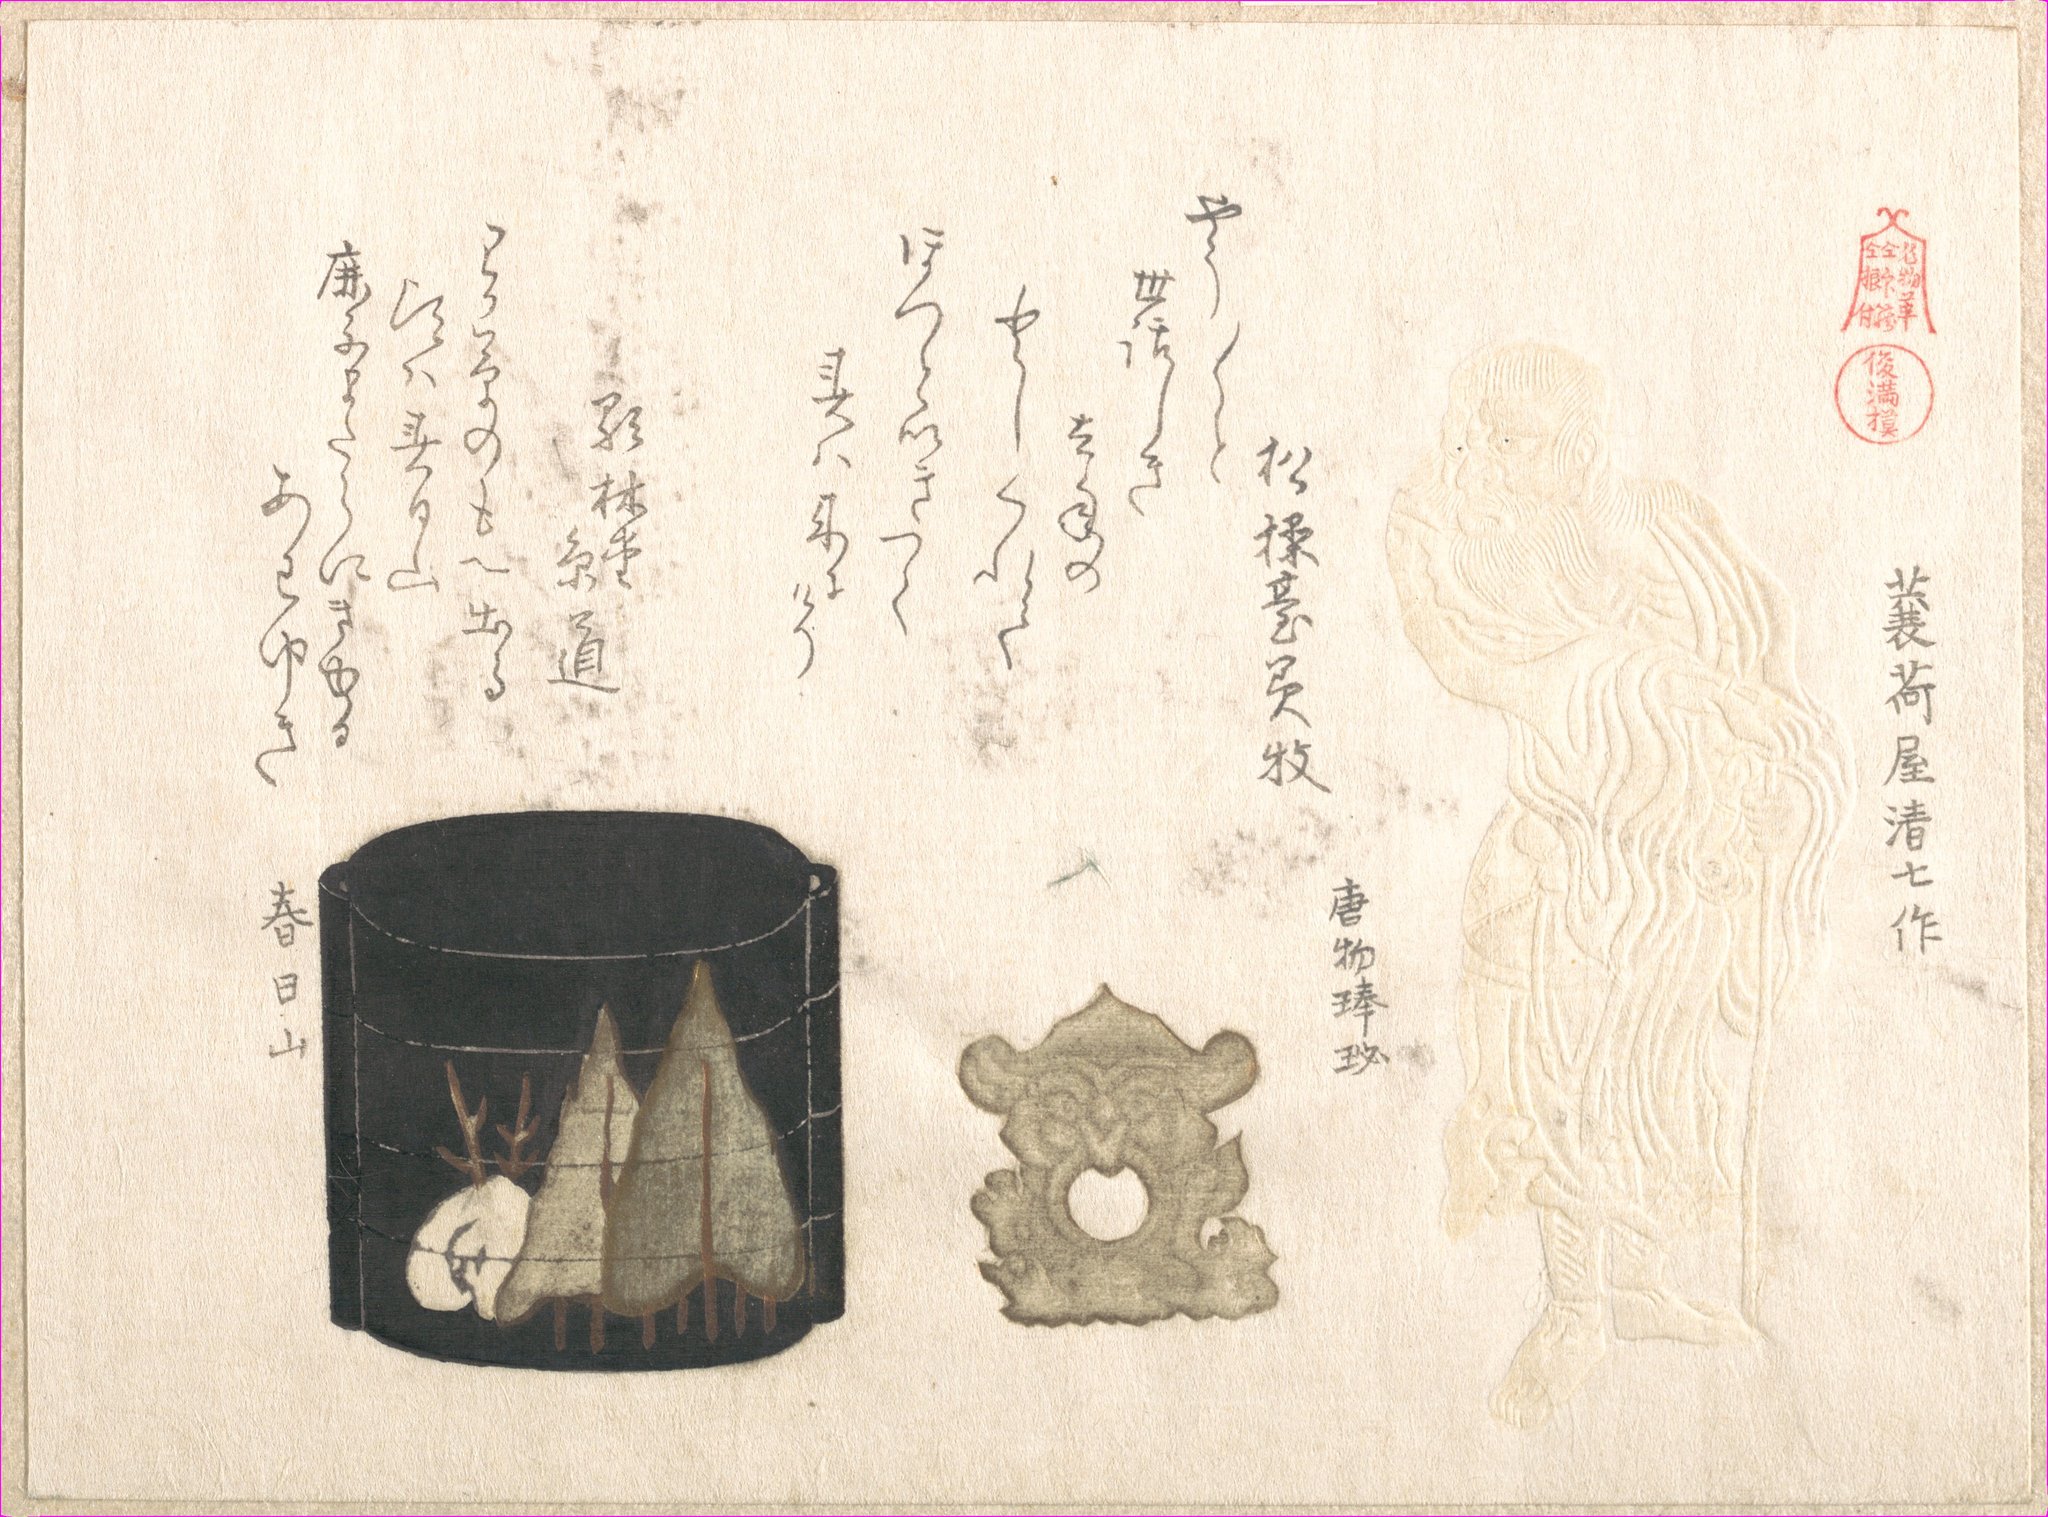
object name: print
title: Inro and Two Netsuke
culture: japanese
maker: kubo shunman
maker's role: artist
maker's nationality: japanese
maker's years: 1757-1820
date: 1801-1900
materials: ink, paper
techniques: surimono, woodblock print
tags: netsuke,men